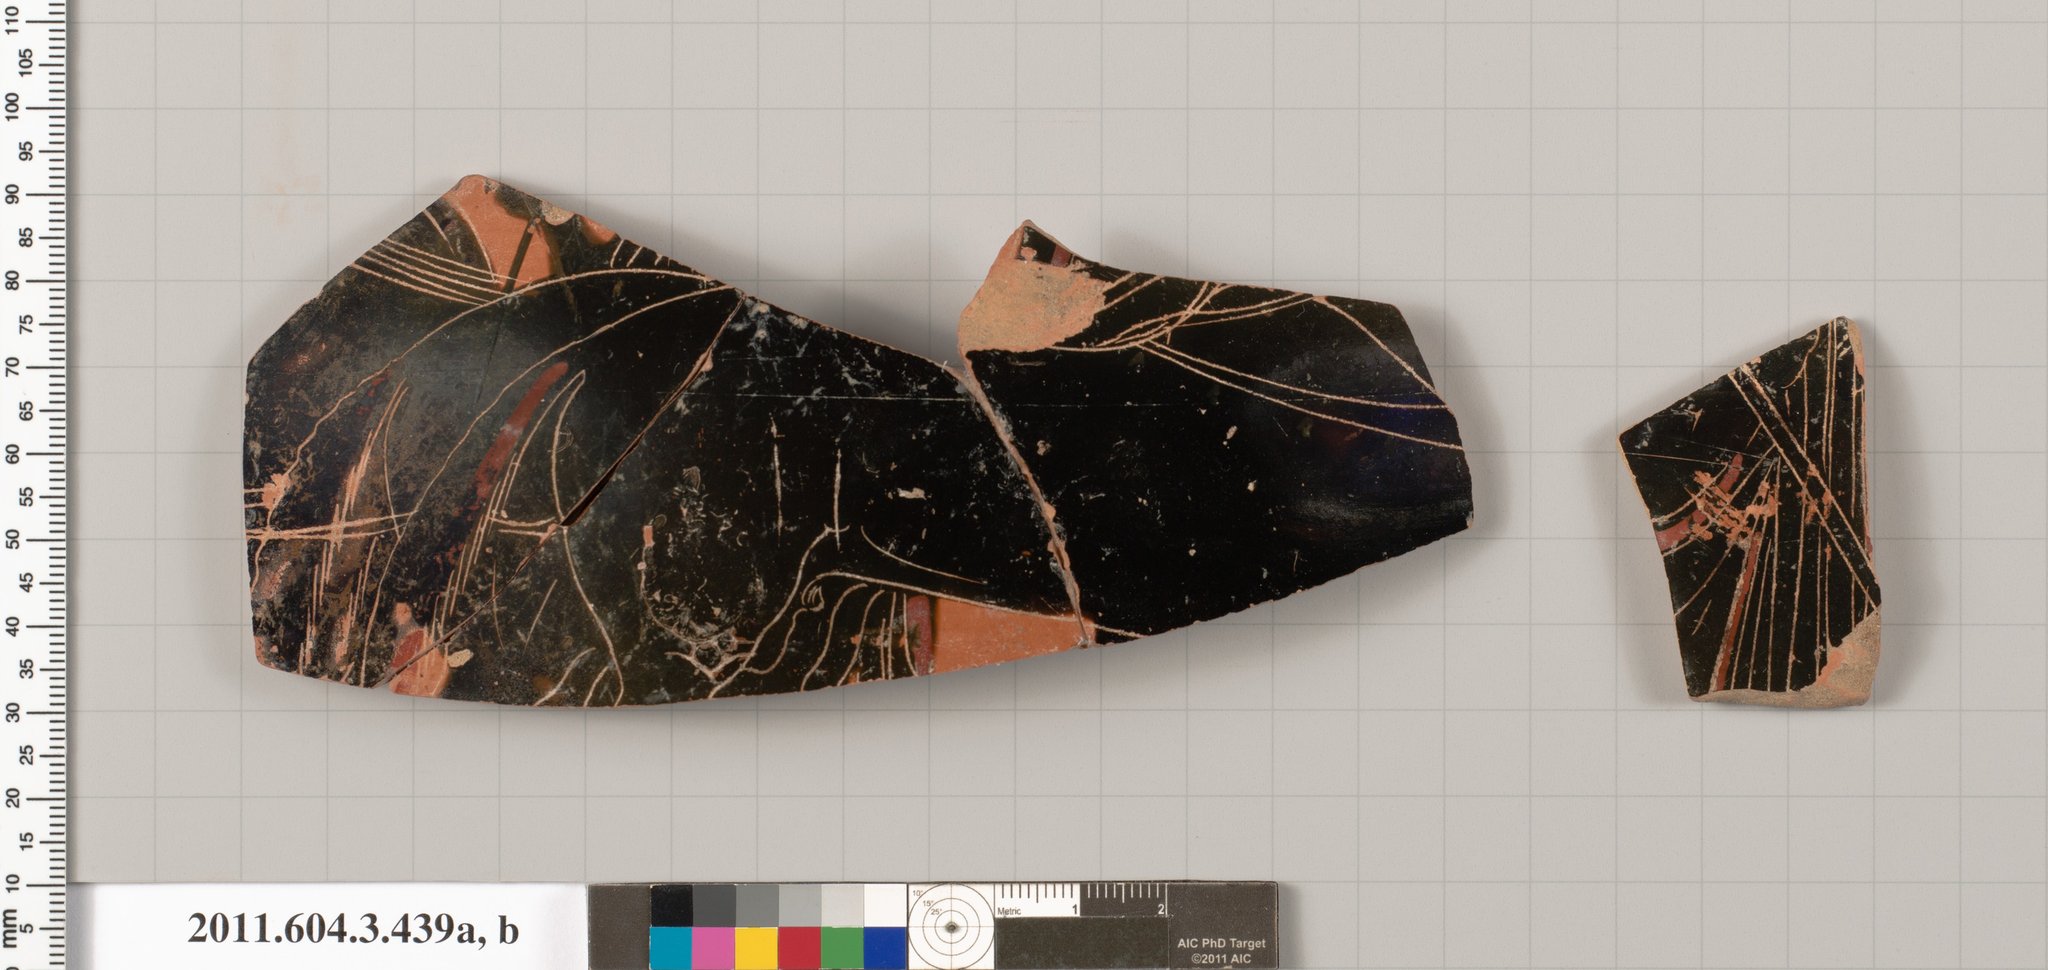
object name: neck amphora fragment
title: Terracotta fragments of a neck-amphora (jar)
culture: greek, attic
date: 550-526 BCE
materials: terracotta